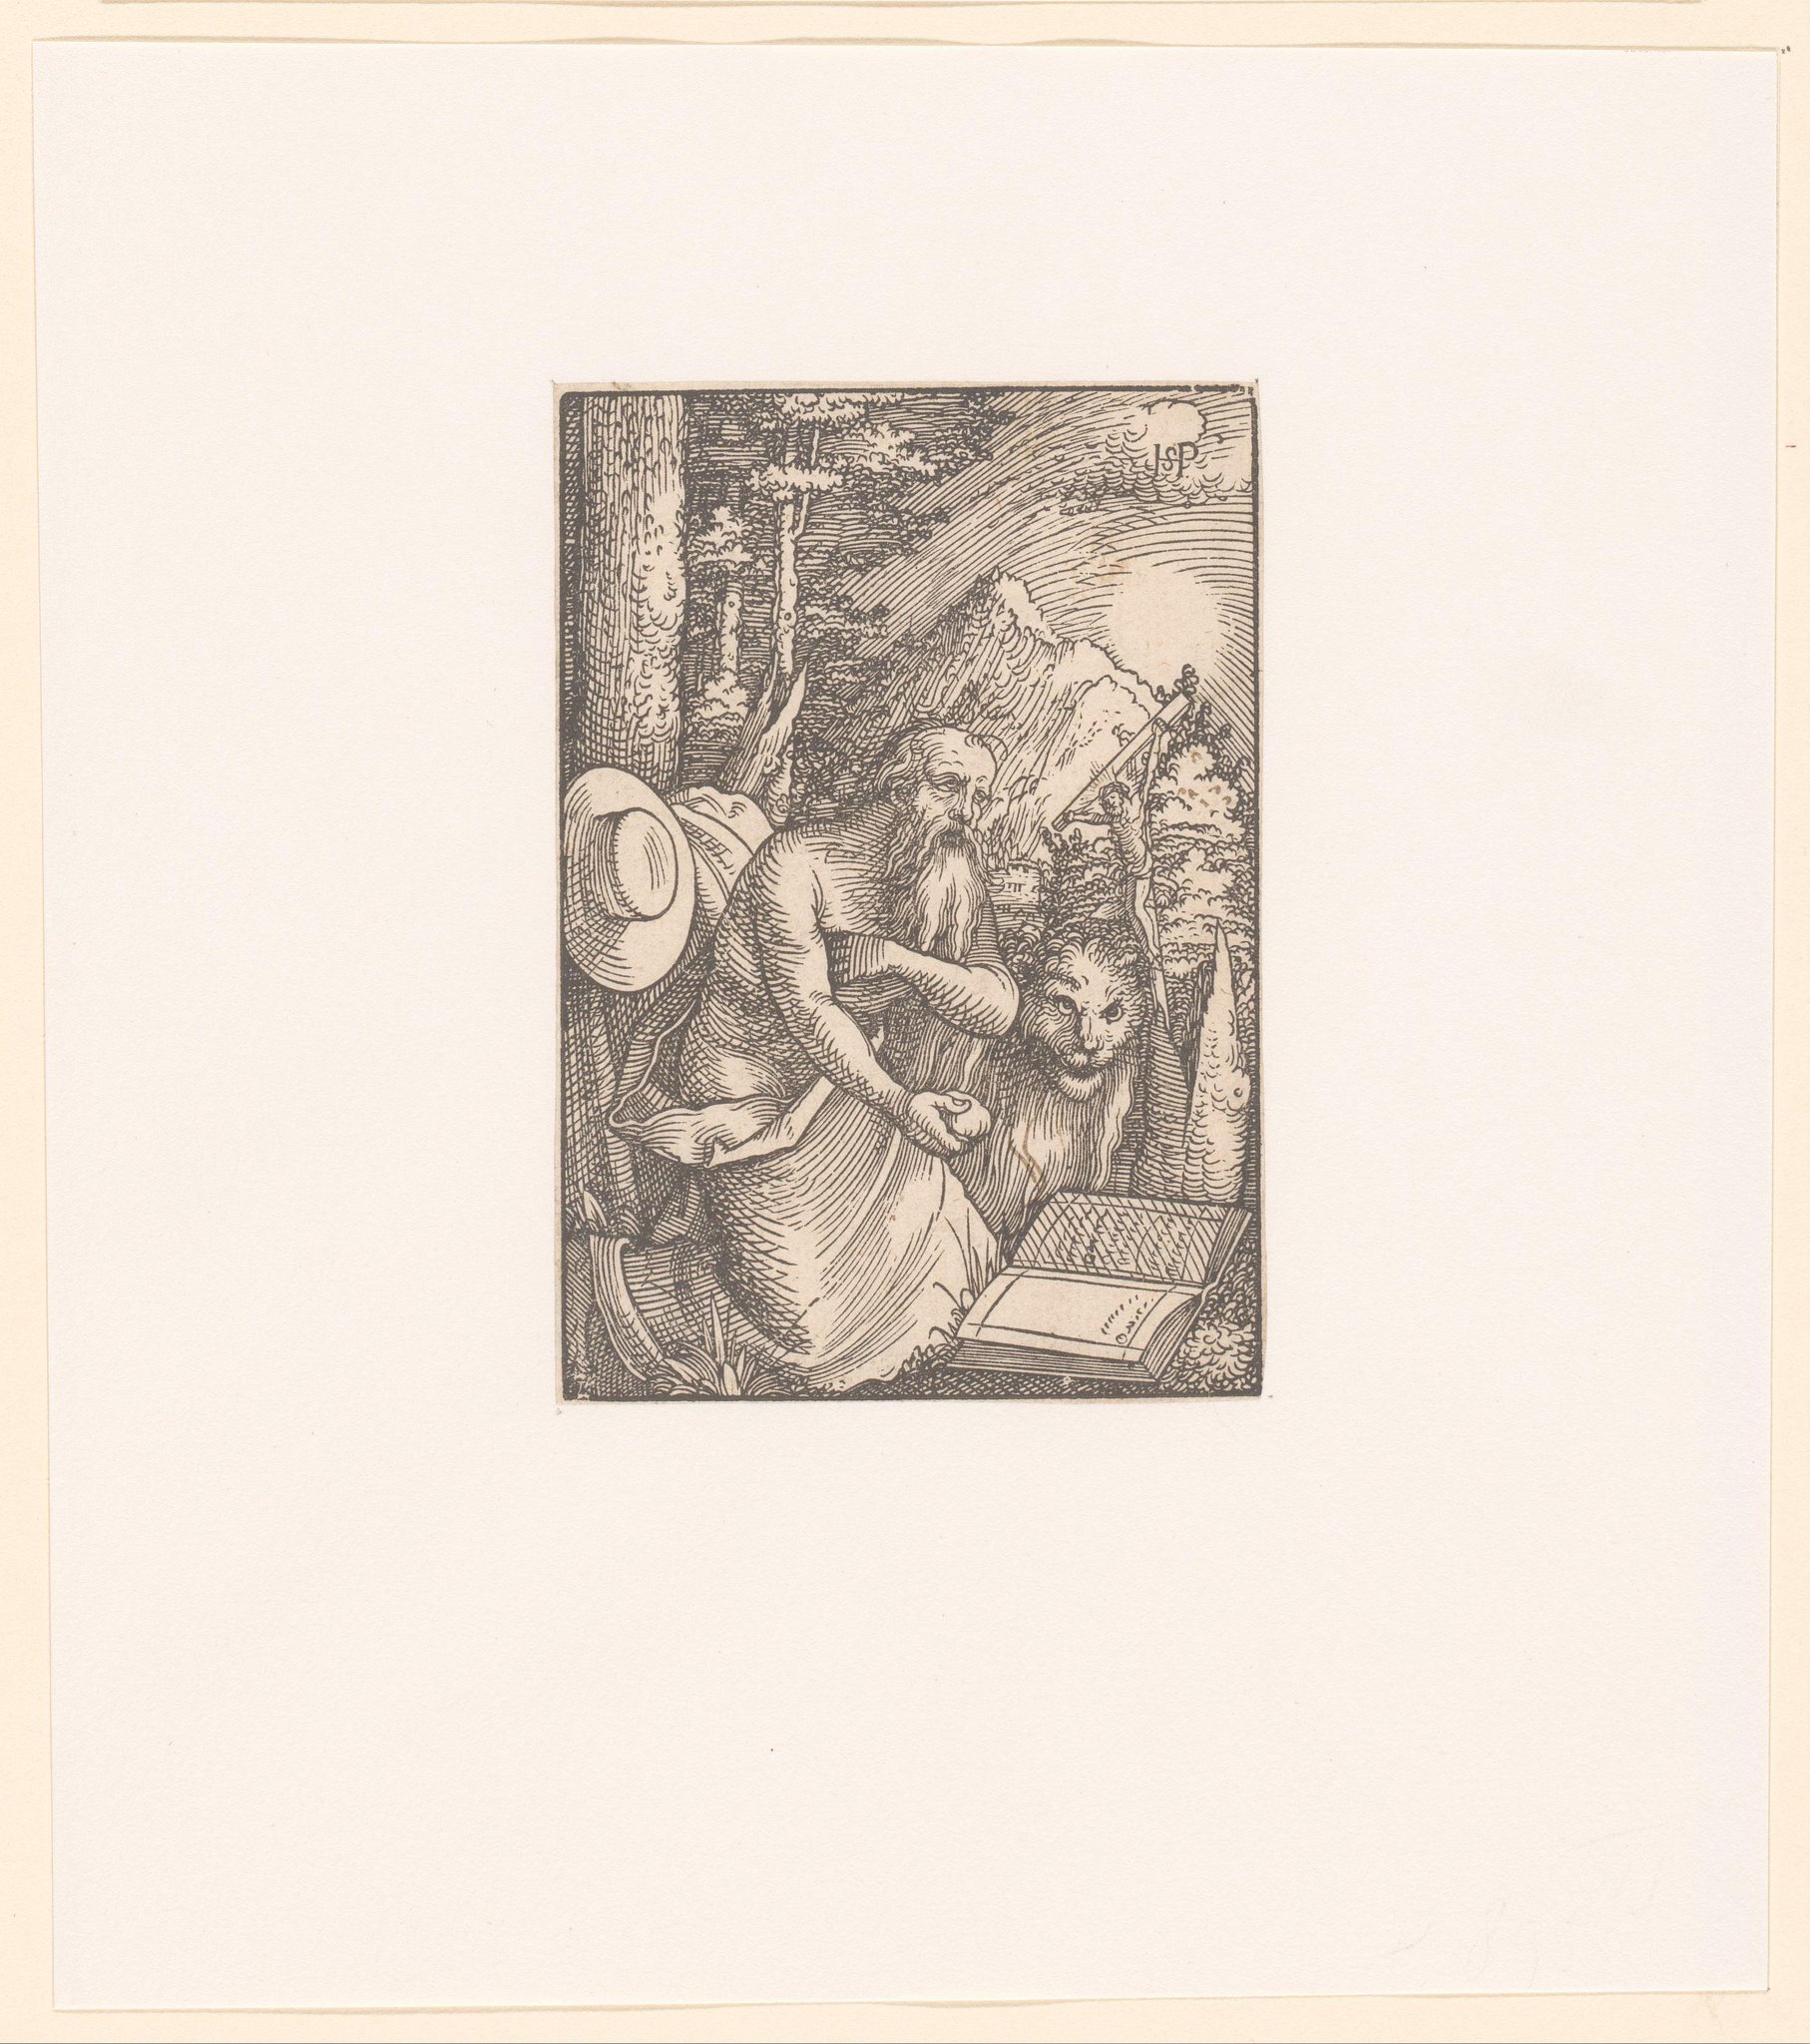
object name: print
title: Heilige Hieronymus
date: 1521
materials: paper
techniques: woodcut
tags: the monk and hermit jerome (hieronymus); possible attributes: book, cardinal's hat, crucifix, hour-glass, lion, skull, stone